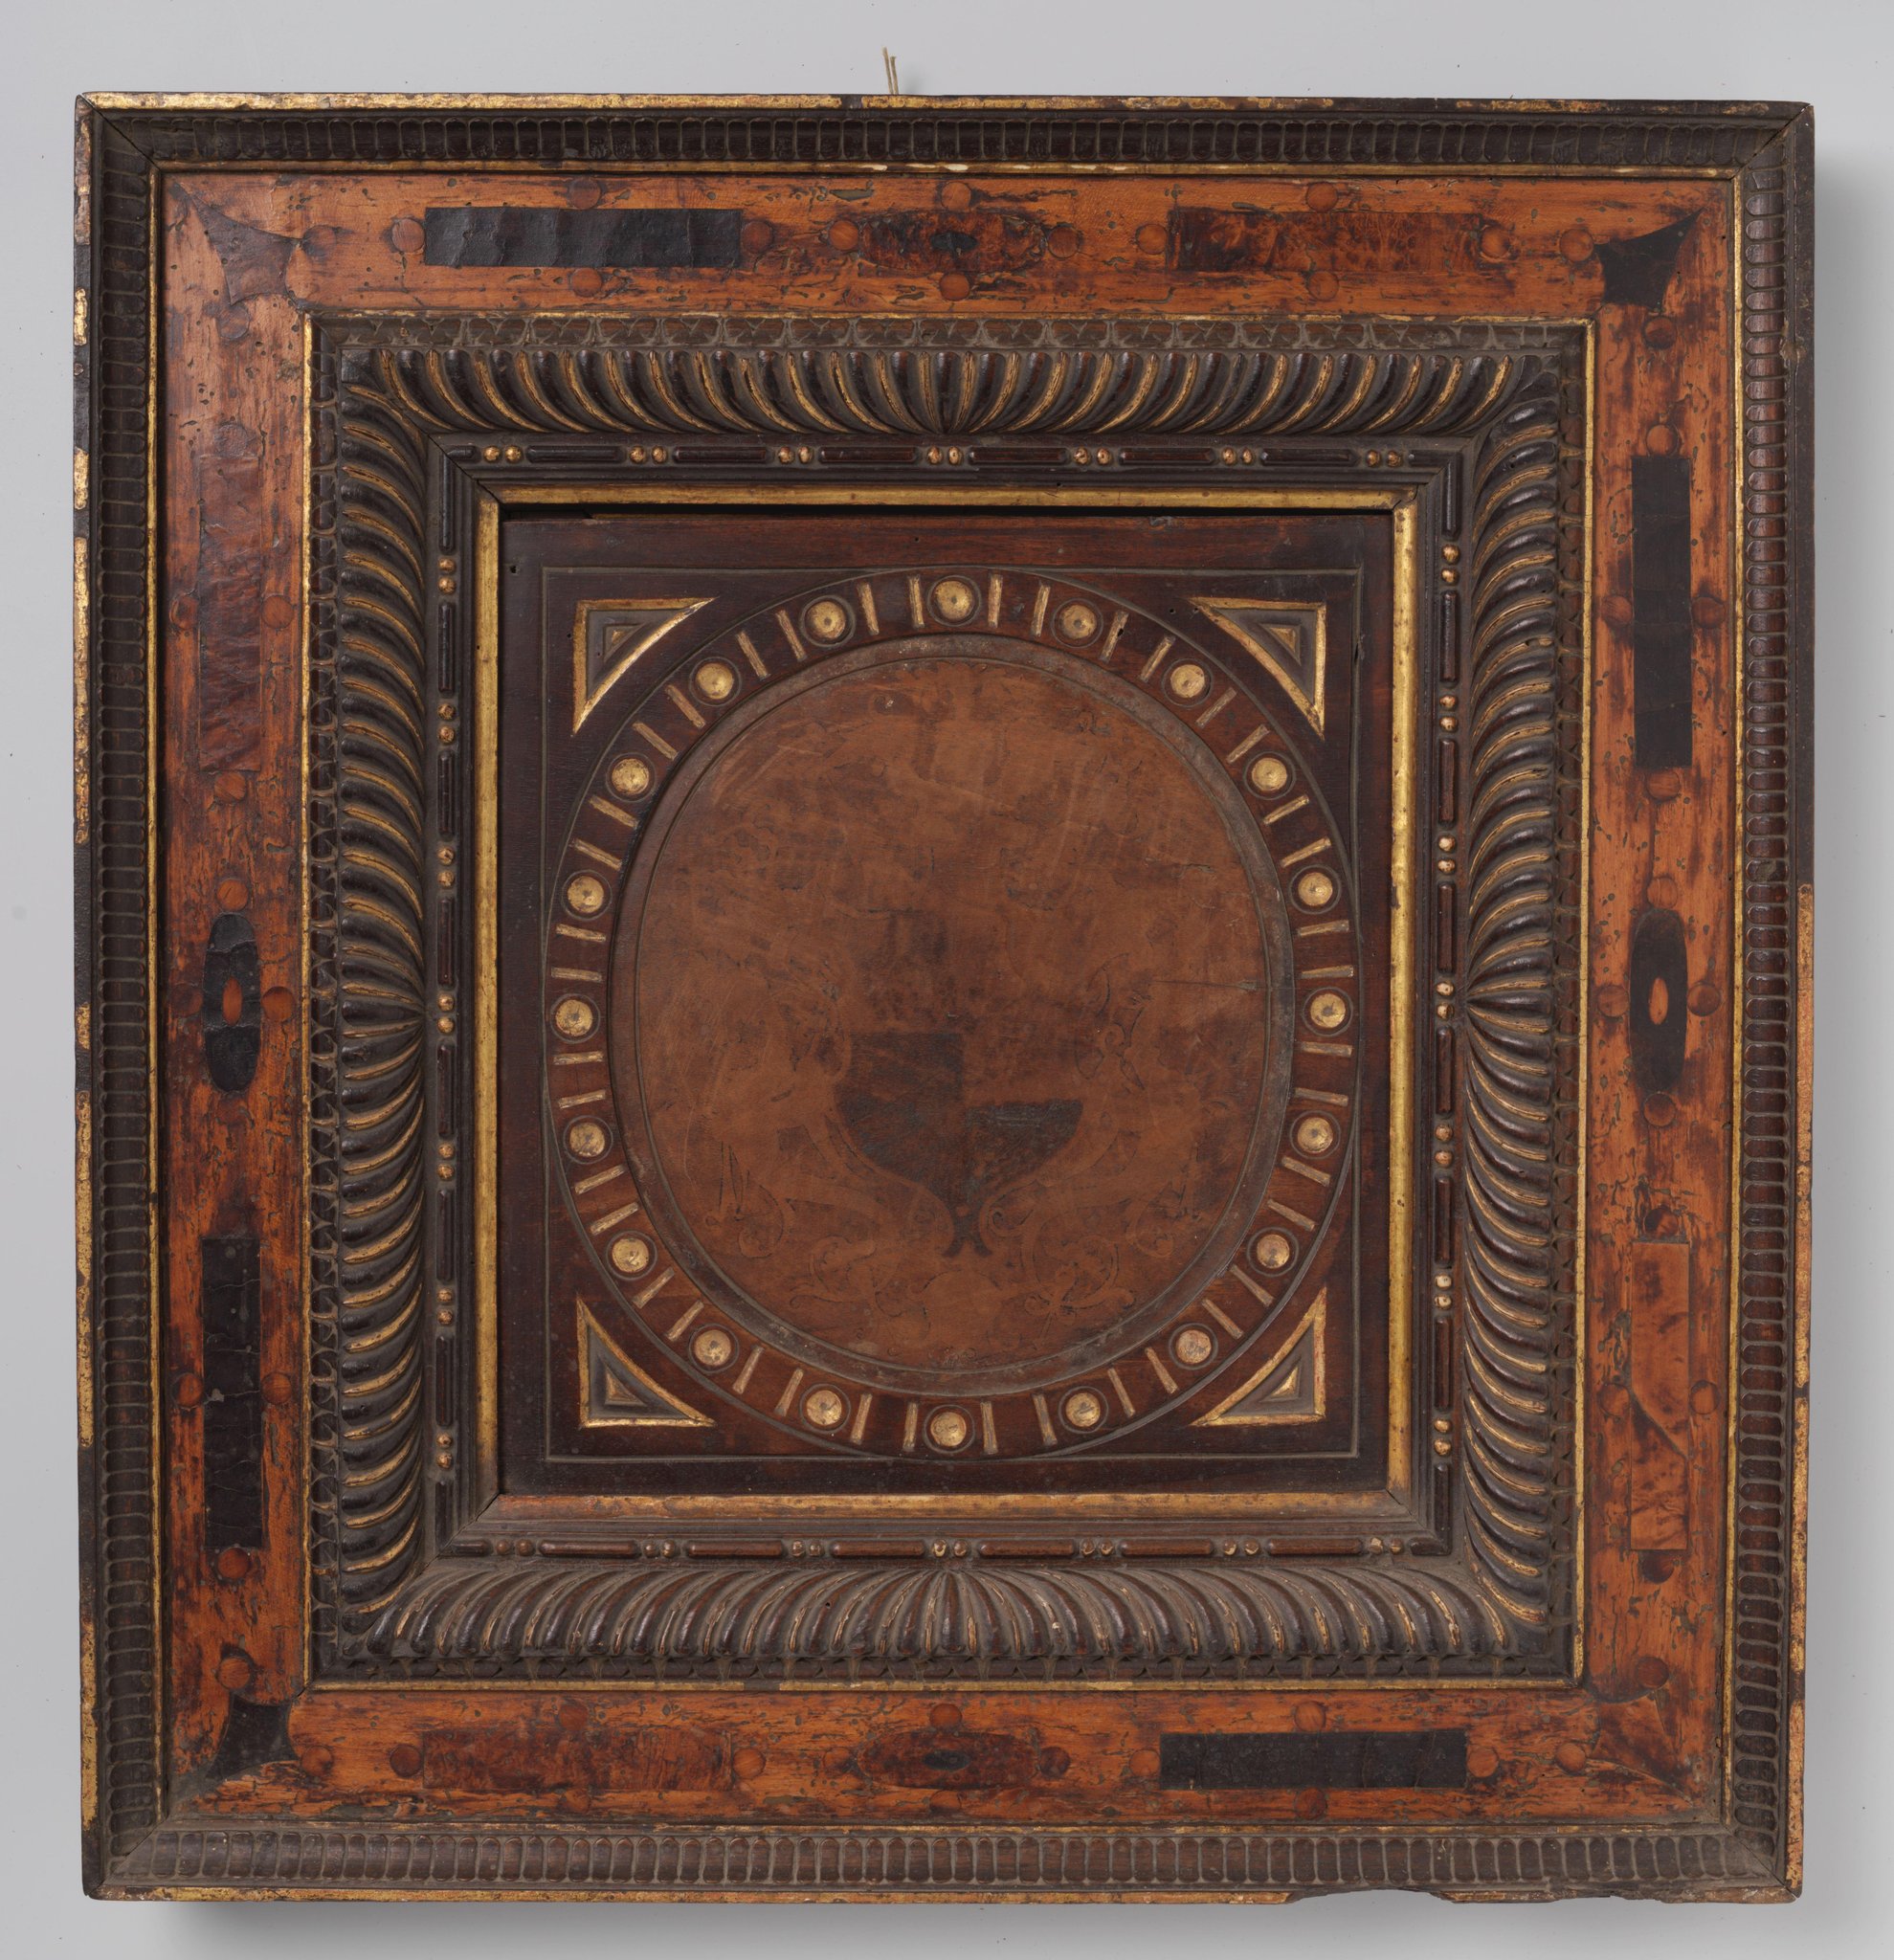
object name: spiegellijst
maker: Anonymous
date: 1500-1600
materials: wood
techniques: gilding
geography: italy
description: Spiegellijst van noten- en ebbenhout op populierenhouten raam, plaatselijk verguld, met notenhouten schuifblad, dat binnen een rand met kleine cirkelholten en inkervingen een ovaal vertoont. Om de schuif een lijst met gestoken toegewende knorren, die gevat is binnen een vlakke lijst met geprofileerde rand met gestoken platte versieringen van ovale vorm. De vlakke lijst is met wortelnotenhout en ebbenhout belijmd. Op het schuifblad was een wapen geschilderd, waarvan nog sporen zichtbaar zijn.